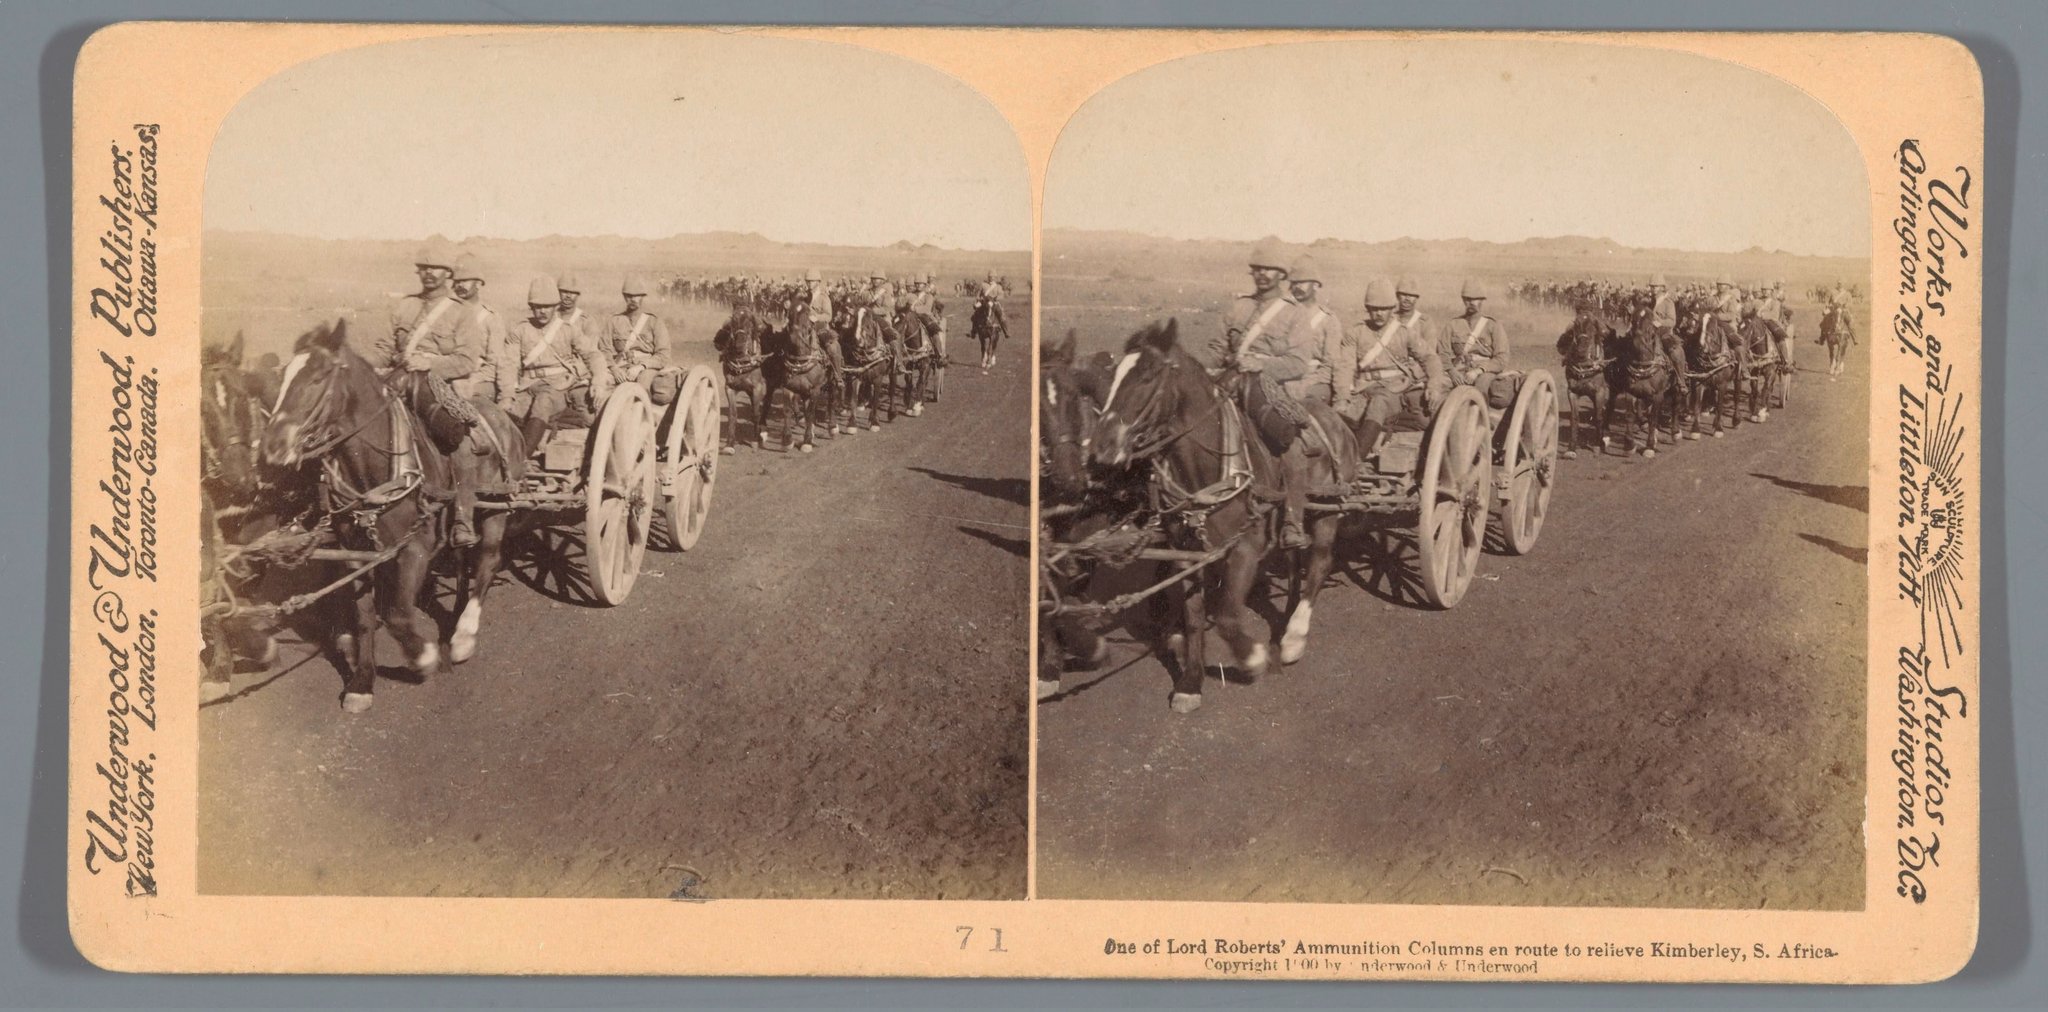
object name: stereograph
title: Gezicht op het vervoer van ammunitie naar Kimberley onder het bevel van Lord Roberts (Frederick Sleigh Roberts)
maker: Anonymous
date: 1900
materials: cardboard, paper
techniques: albumen print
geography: south africa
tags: troop movements, transportation, four-wheeled vehicle drawn by more than three animals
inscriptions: inscription, number: ‘71’, inscription: ‘Works and Studios ~/ Arlington, N.J. Littleton, N.H. Washington, D.C.’, copyright notice: ‘Copyright 1900 by Underwood & Underwood.’